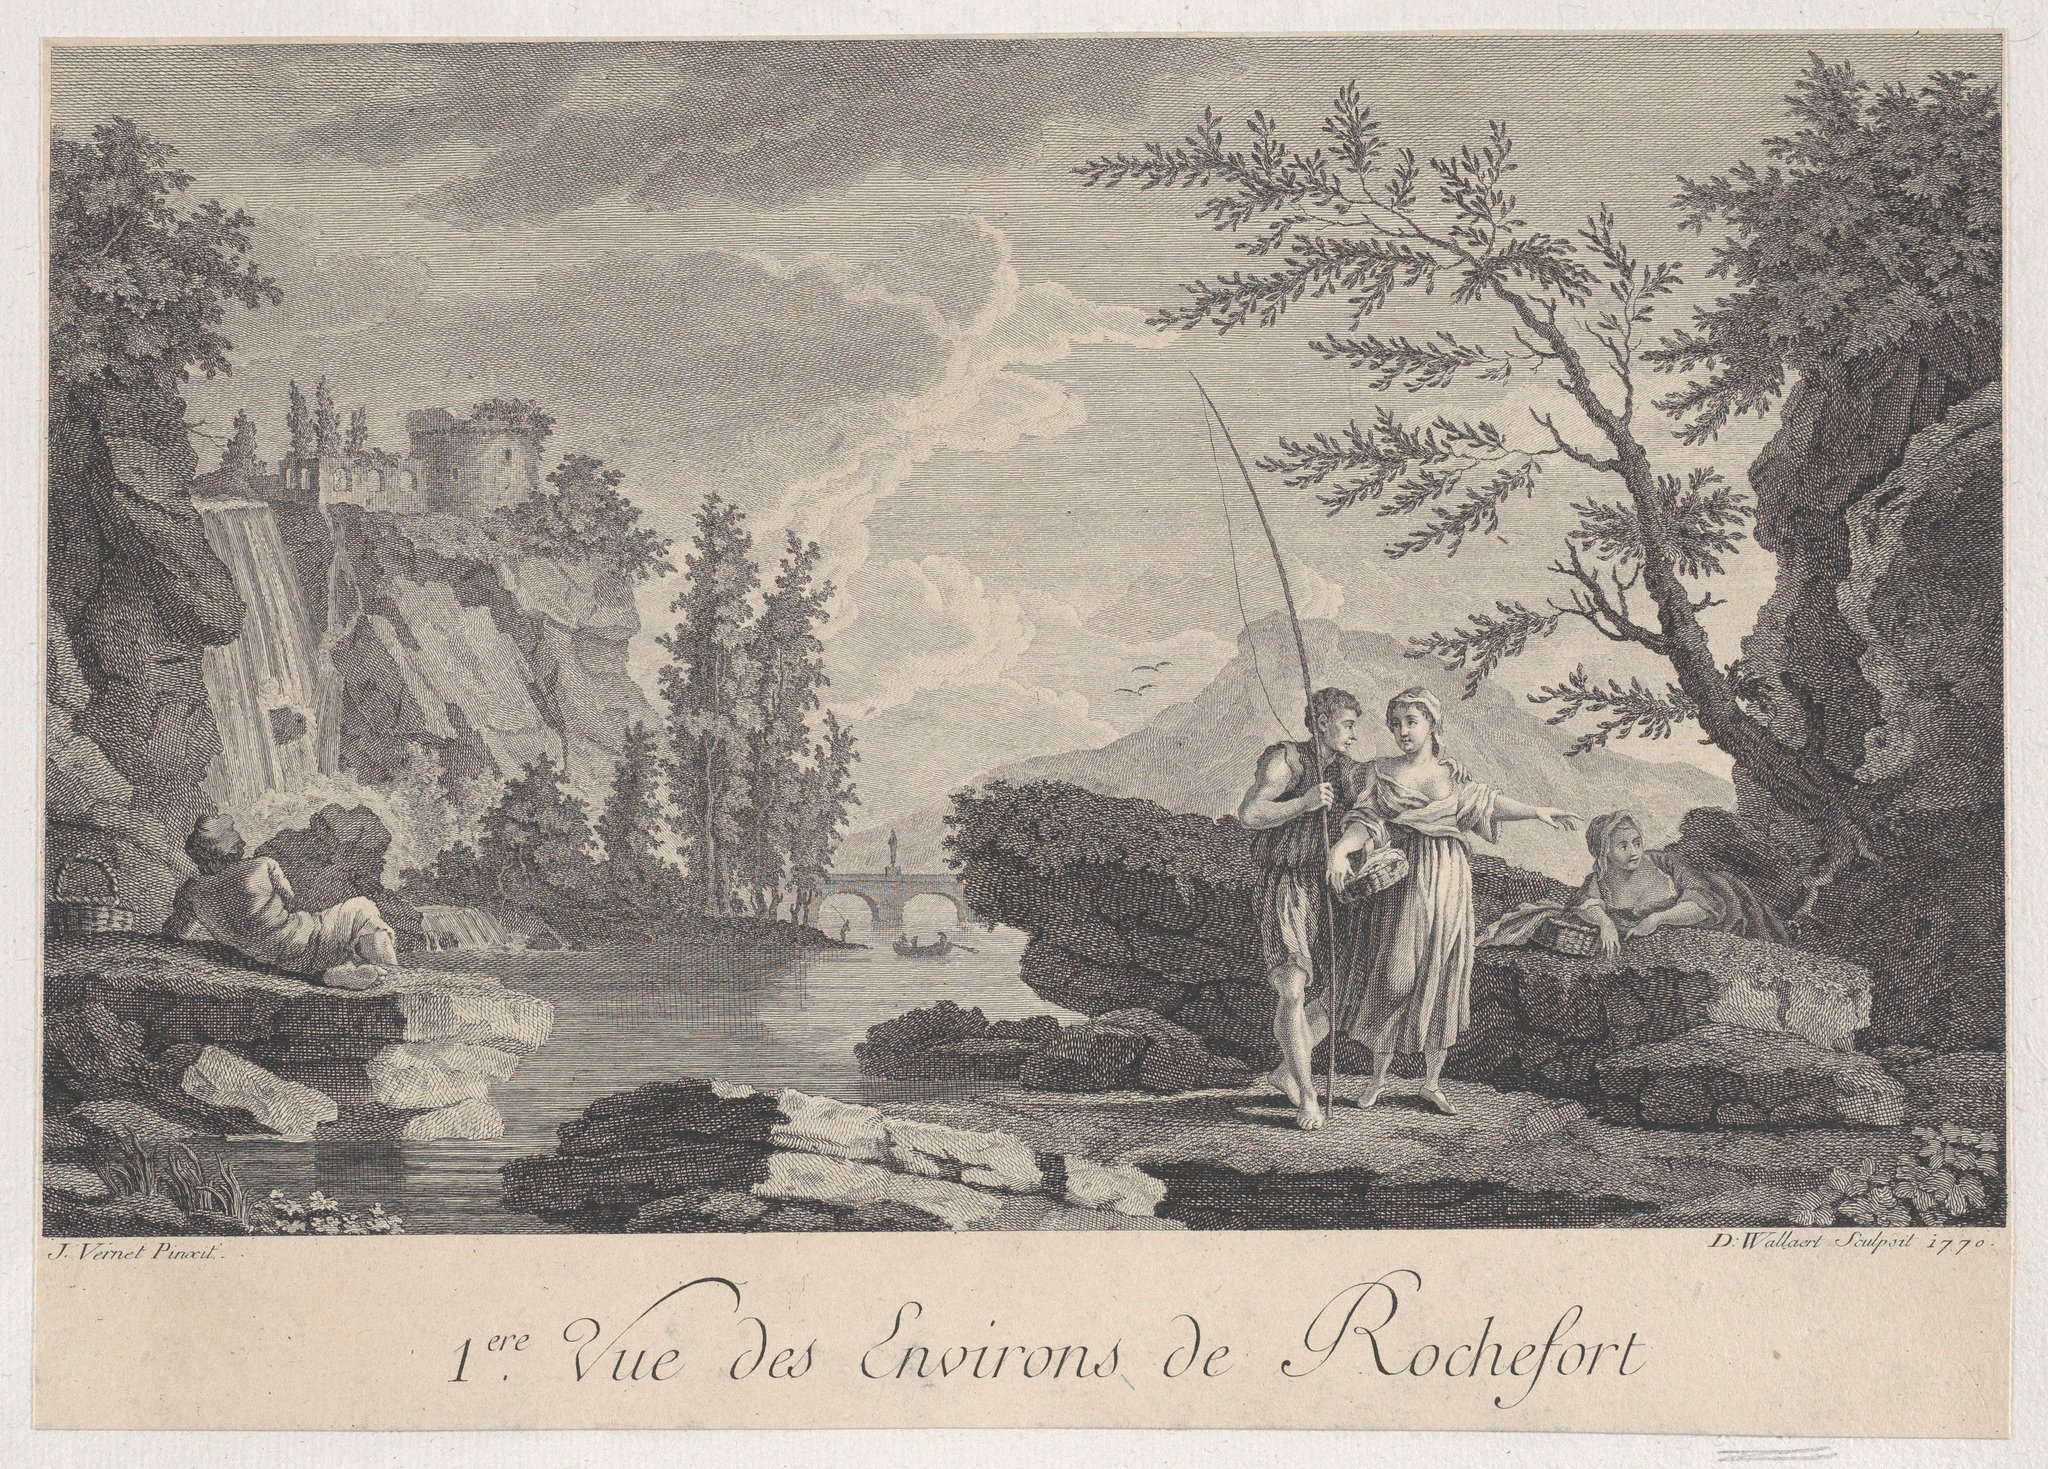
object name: print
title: First View of the Surroundings of Rochefort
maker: joseph vernet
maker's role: artist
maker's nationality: french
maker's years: 1714-1789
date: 1770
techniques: engraving